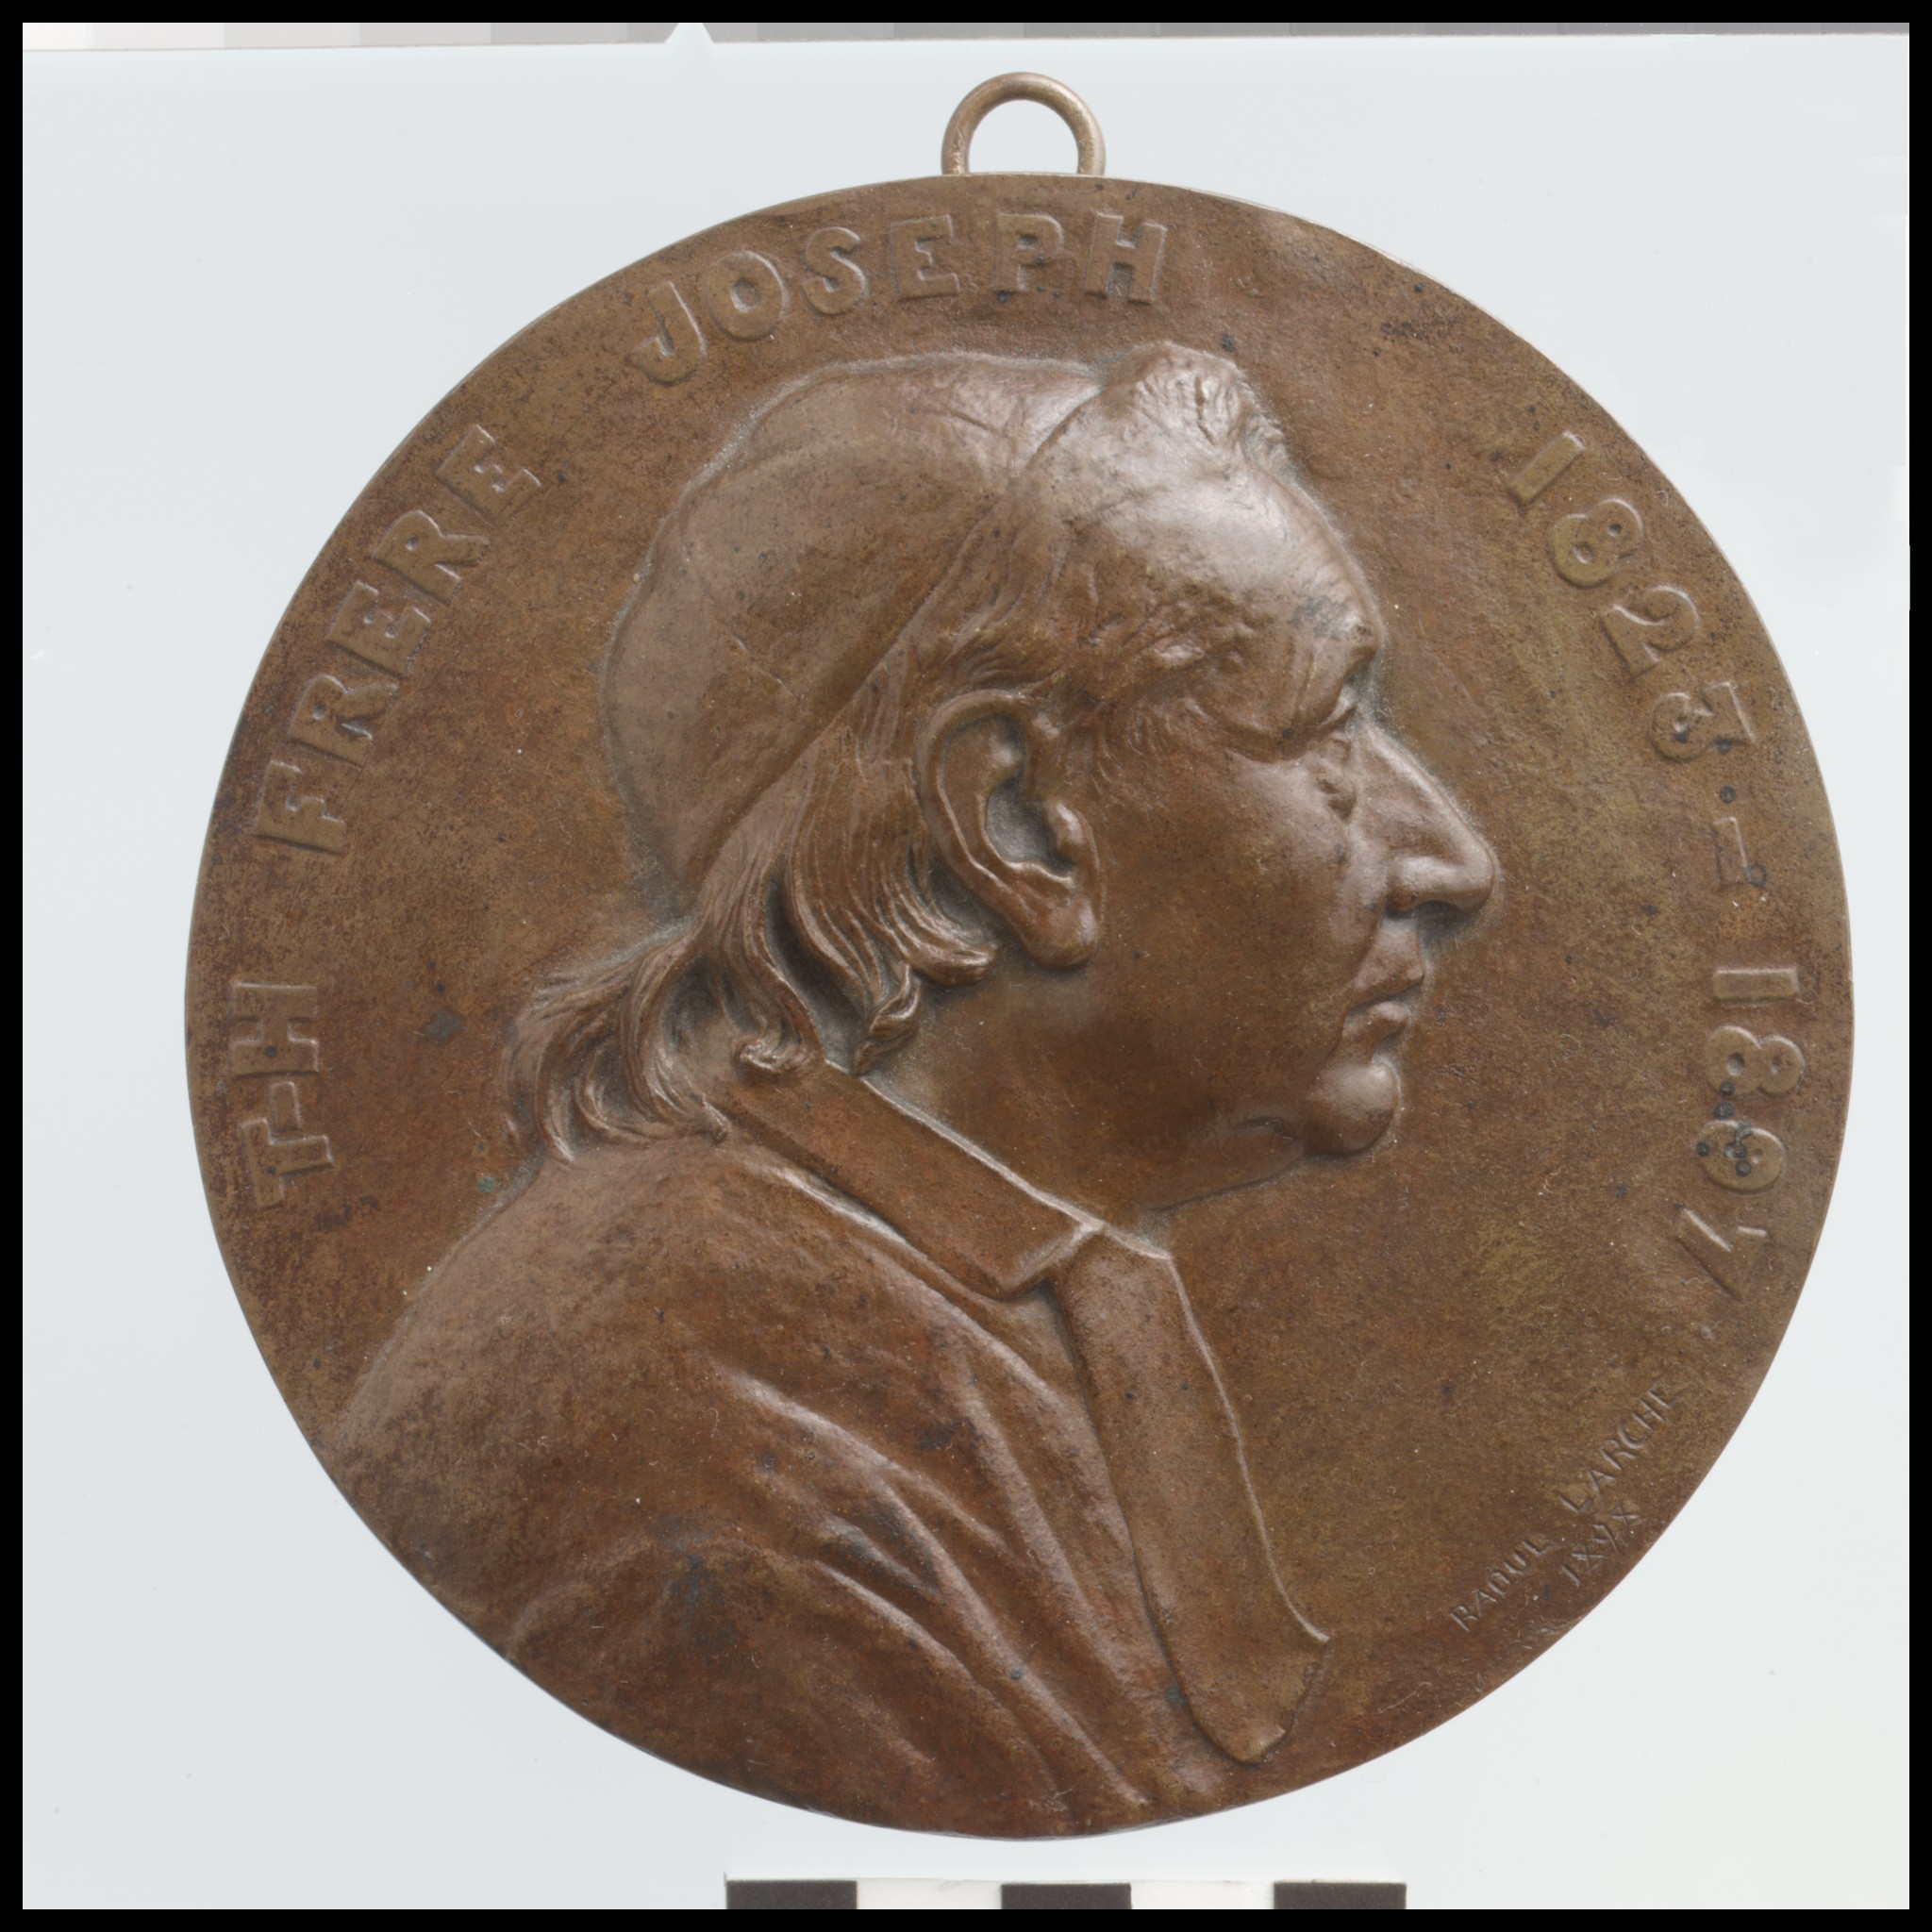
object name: medal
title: T.-H. Frere Joseph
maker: raoul larche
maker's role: maker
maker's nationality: french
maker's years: 1860-1912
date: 1898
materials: bronze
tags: men,profiles